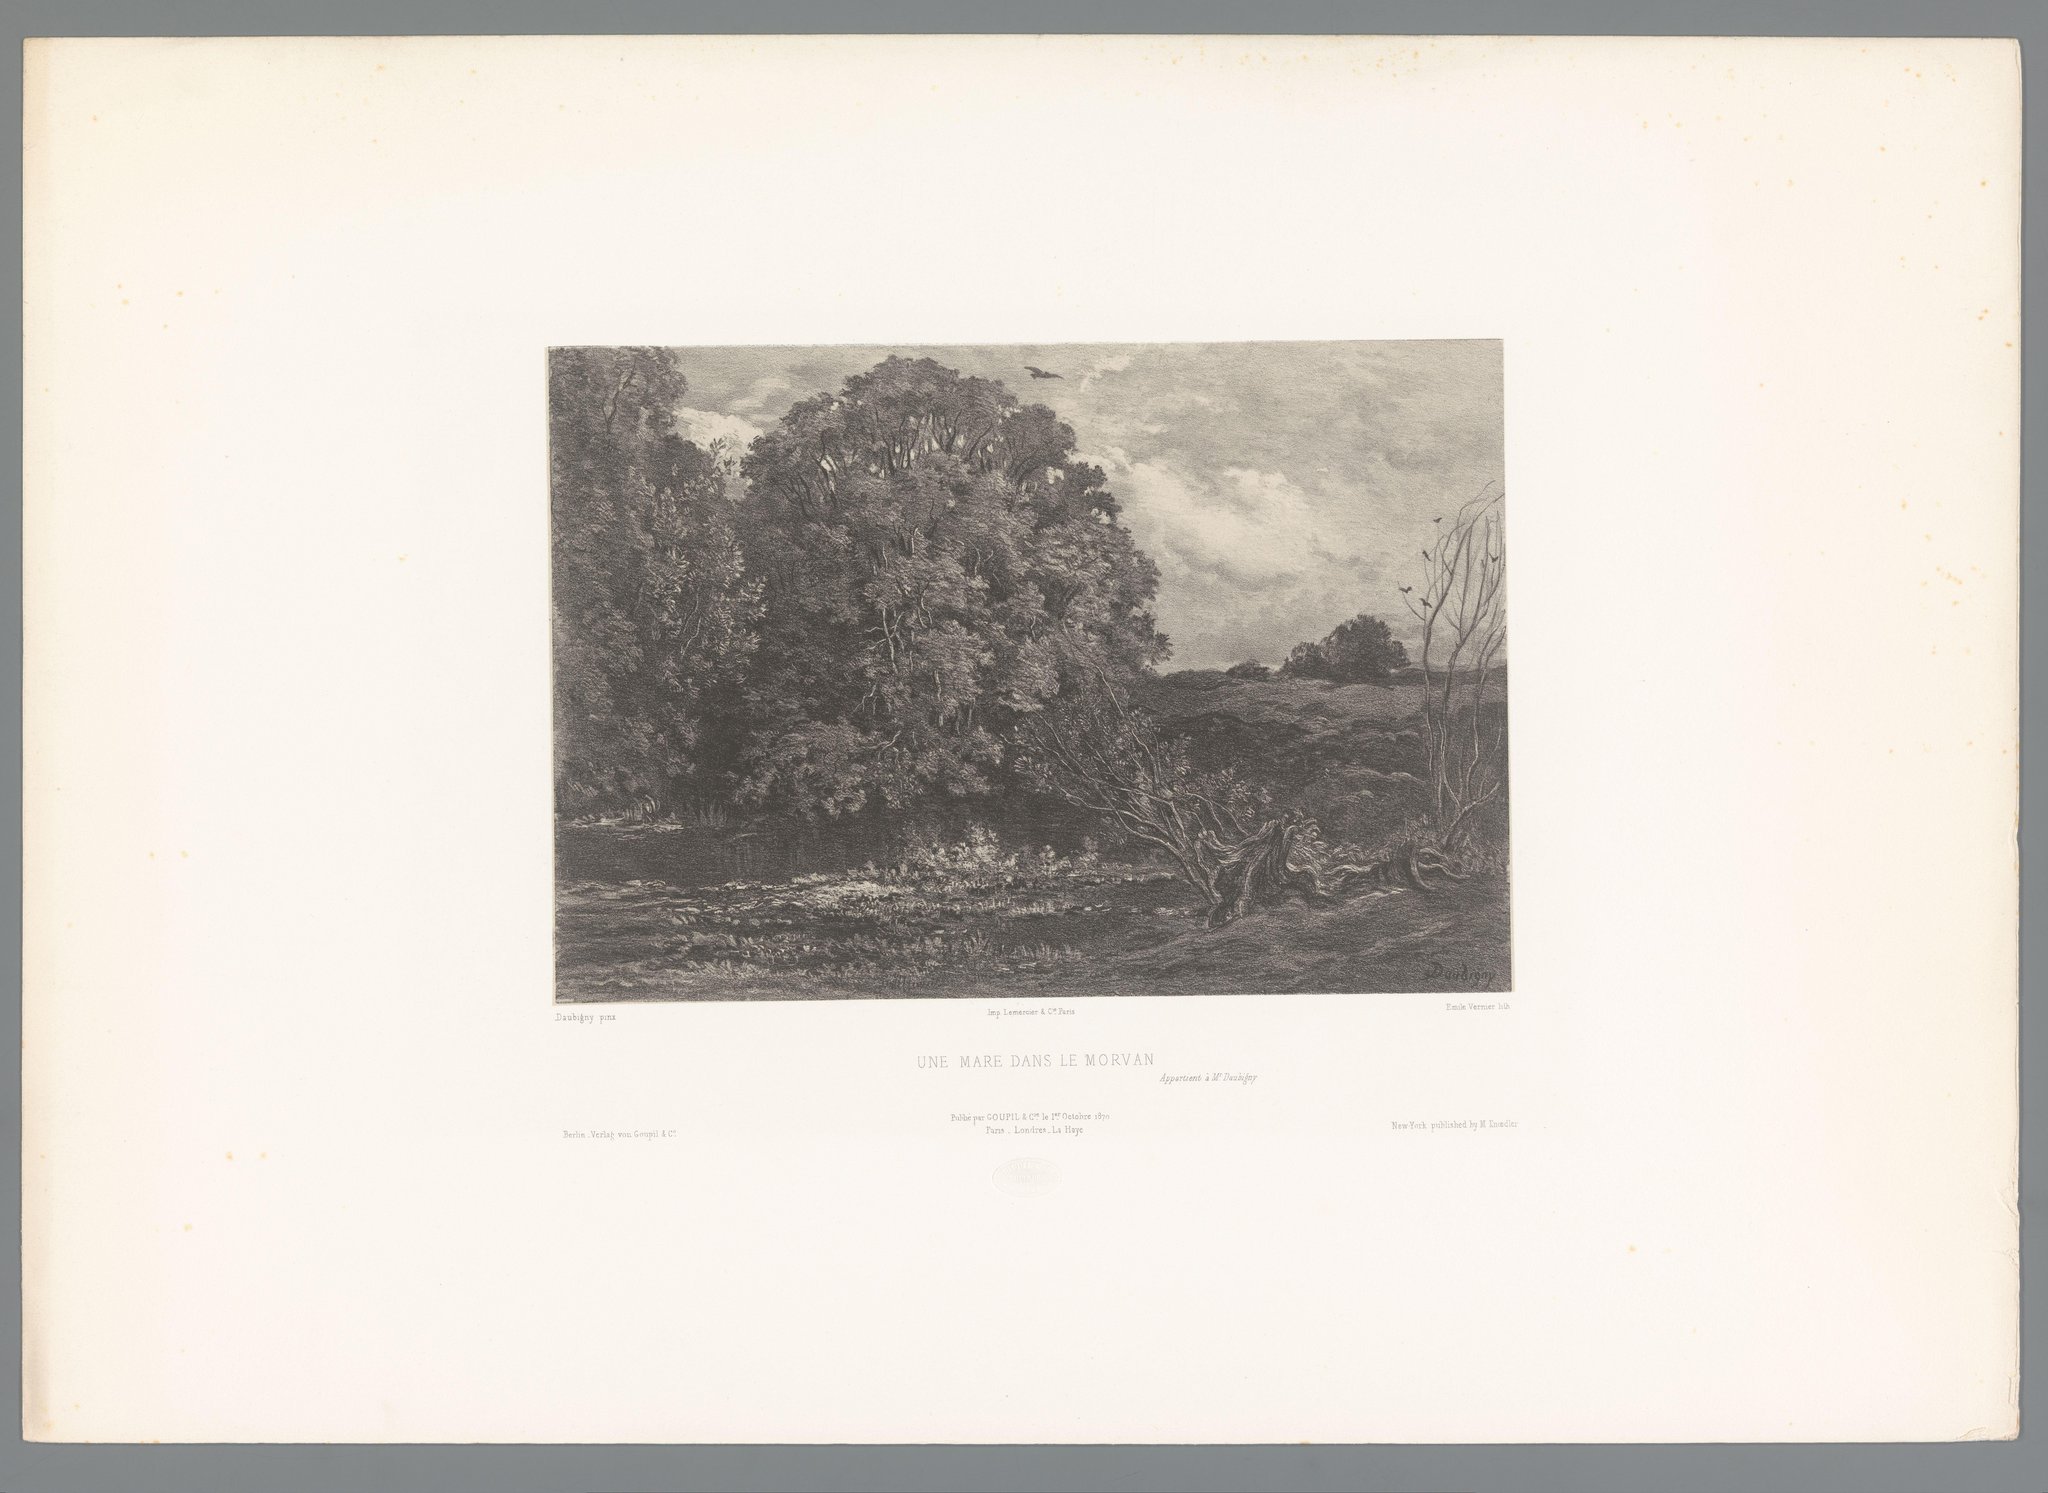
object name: print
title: Douze paysages de Daubigny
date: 1870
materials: paper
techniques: lithograph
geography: new york city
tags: landscapes with waters, waterscapes, seascapes (in the temperate zone)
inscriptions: collector's mark: Lugt 1090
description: Het volgnummer in de serie is niet vermeld.